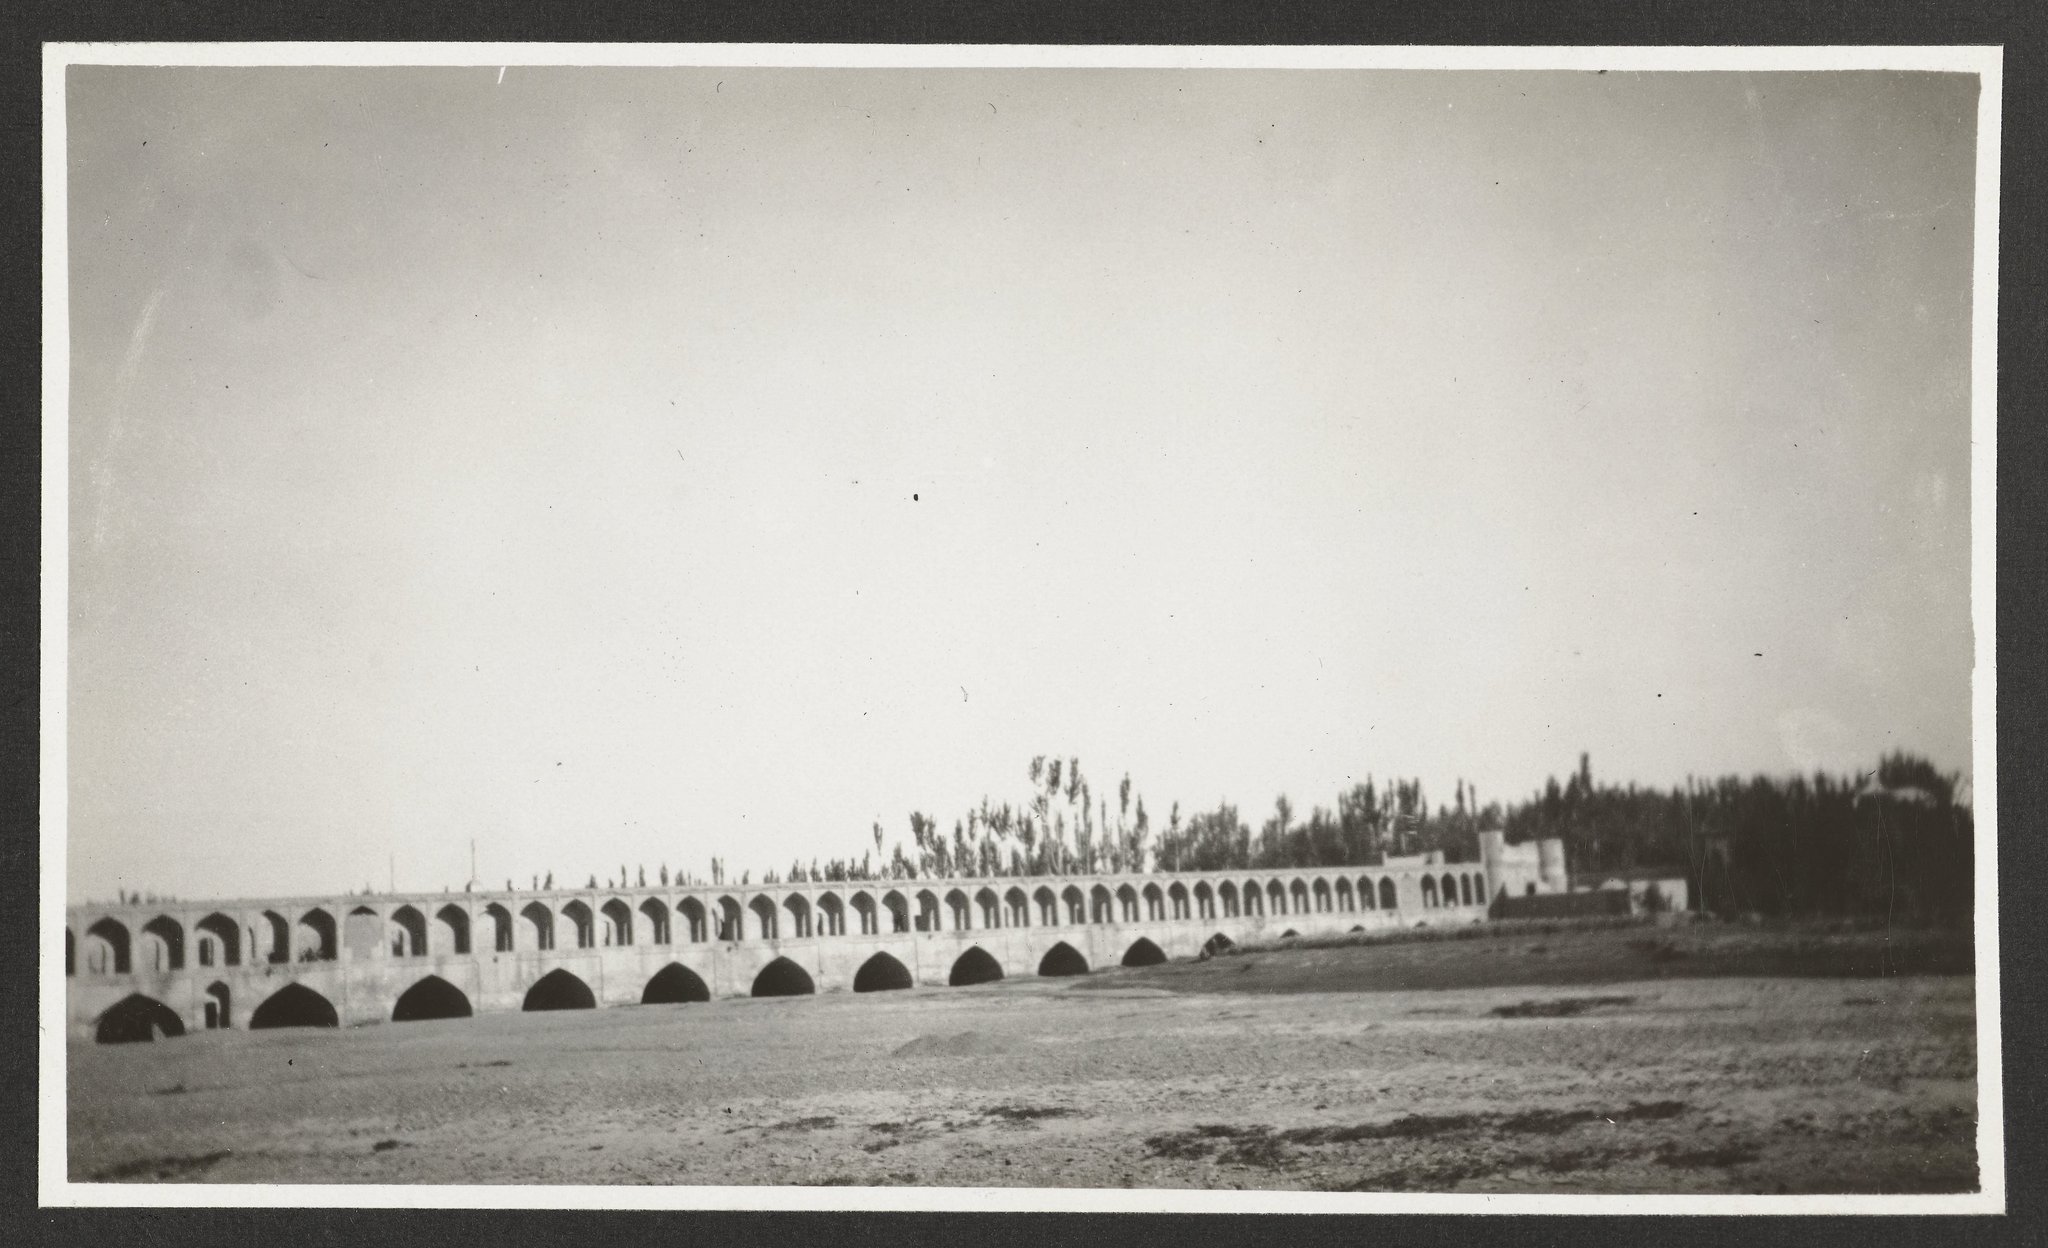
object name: photograph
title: Een der bruggen over de rivier Zendeh Rud, ter verbinding van Isphahan met Julfa.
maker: a.g.a. van eelde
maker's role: engineer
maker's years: 1862-1950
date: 1925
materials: cardboard, paper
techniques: gelatin silver print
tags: iran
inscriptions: number: ‘24.’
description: Titel op object afkomstig uit inventaris (Verklaring der Photo's) behorend bij het album.